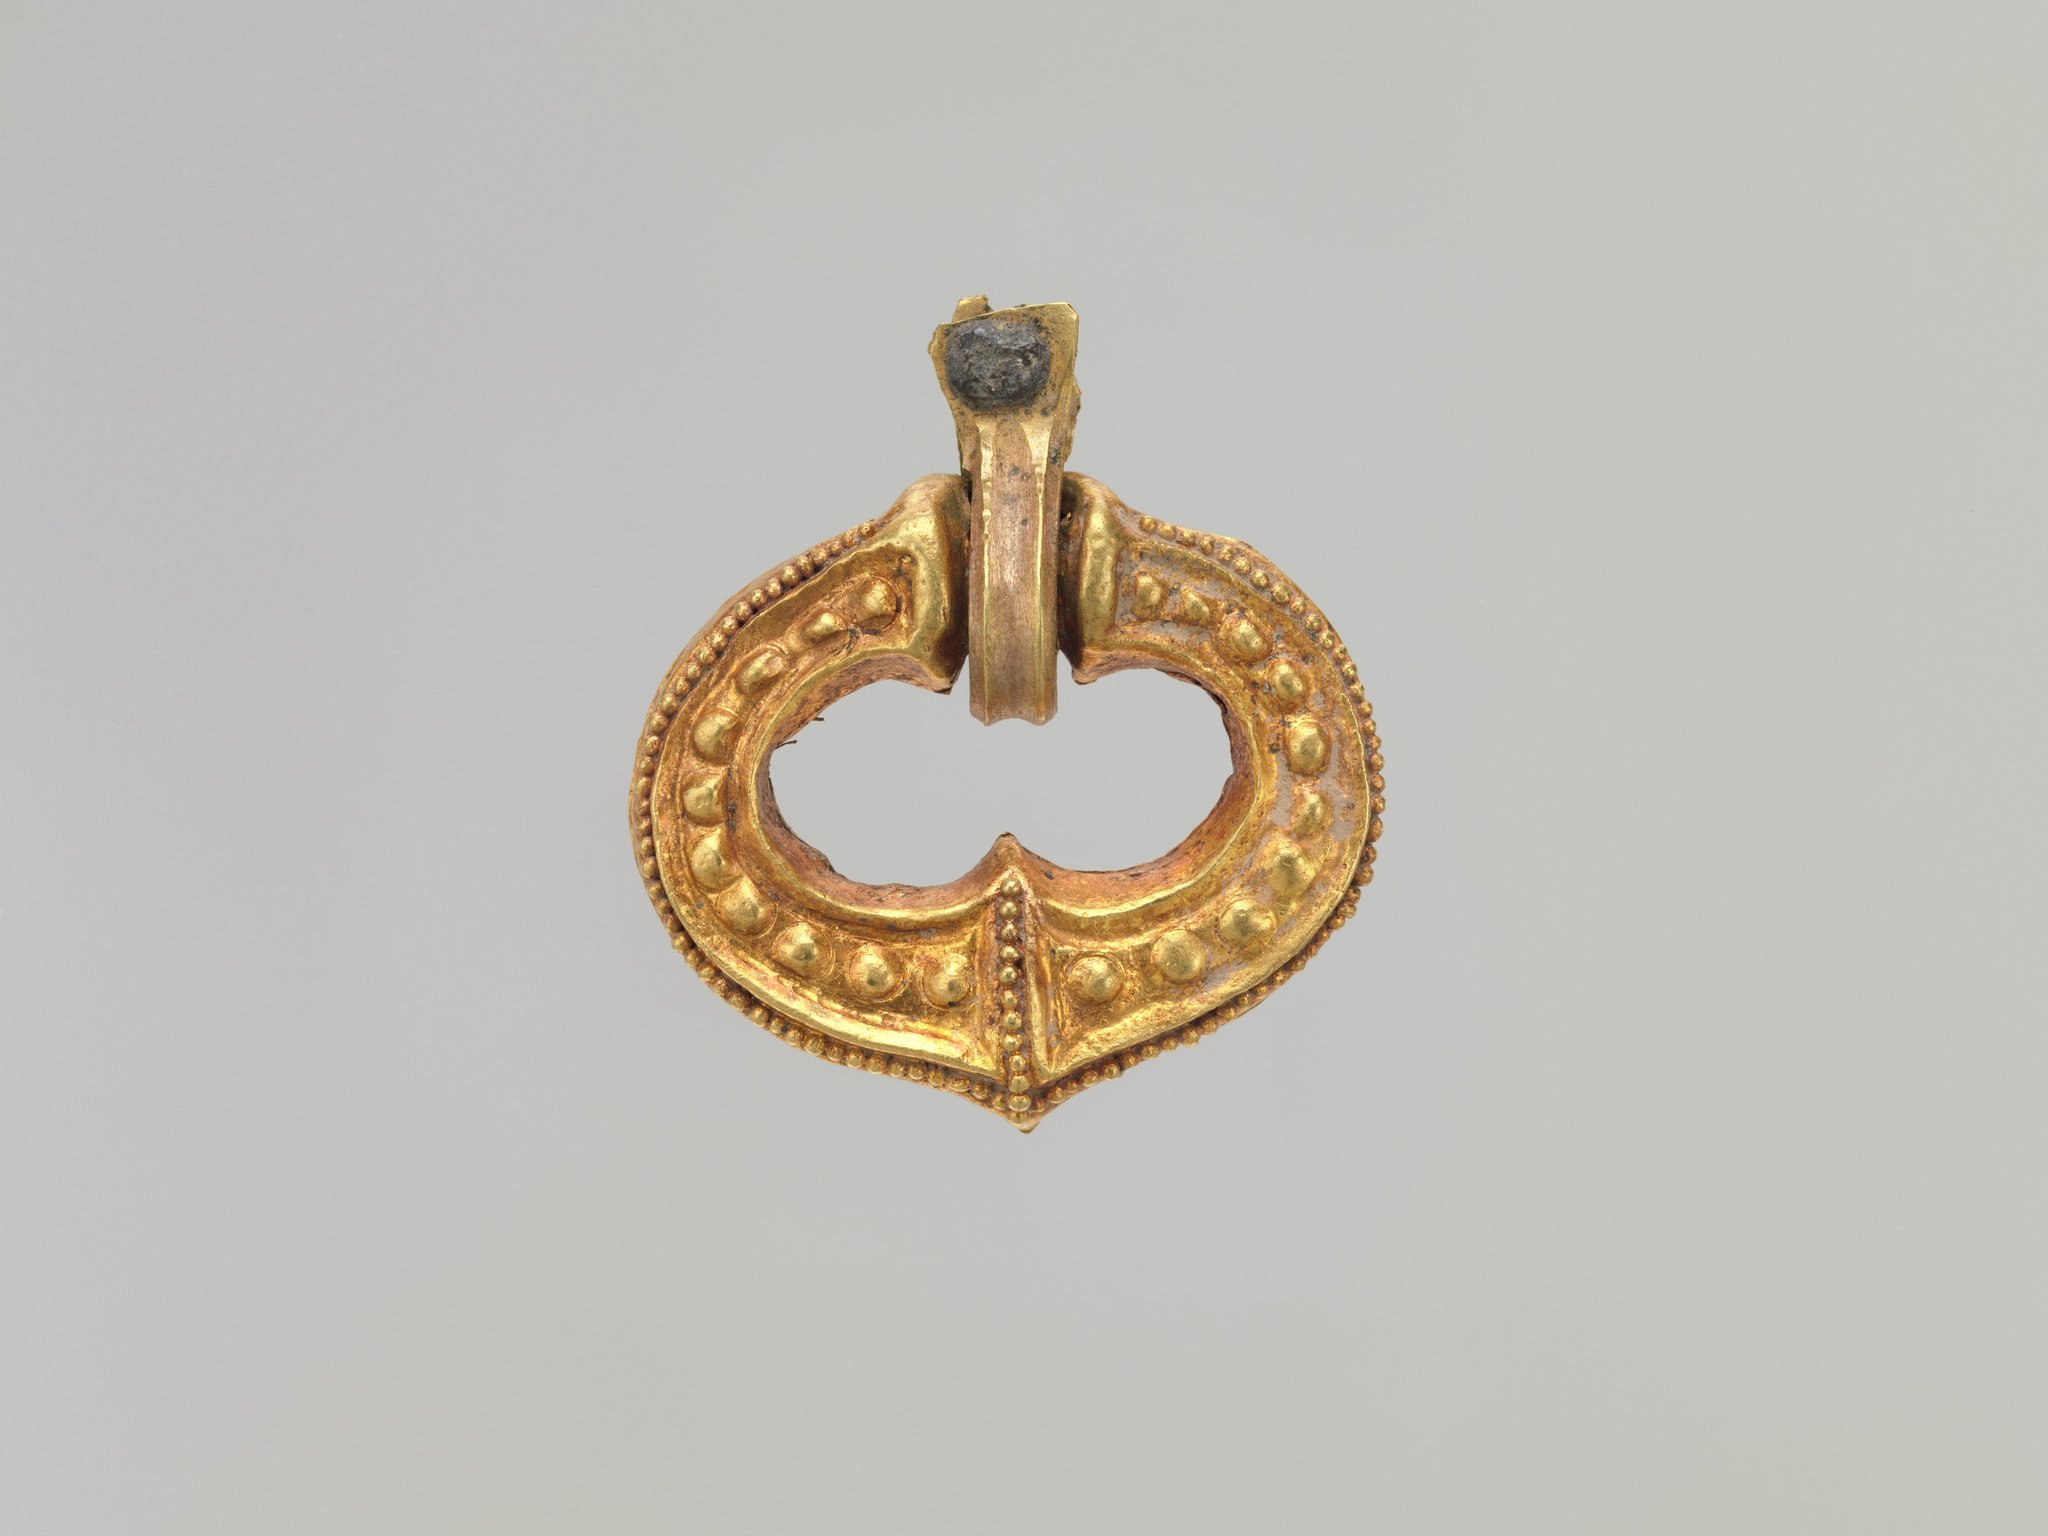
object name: suspension ring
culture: northwest chinese or eastern central asian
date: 634-900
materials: gold